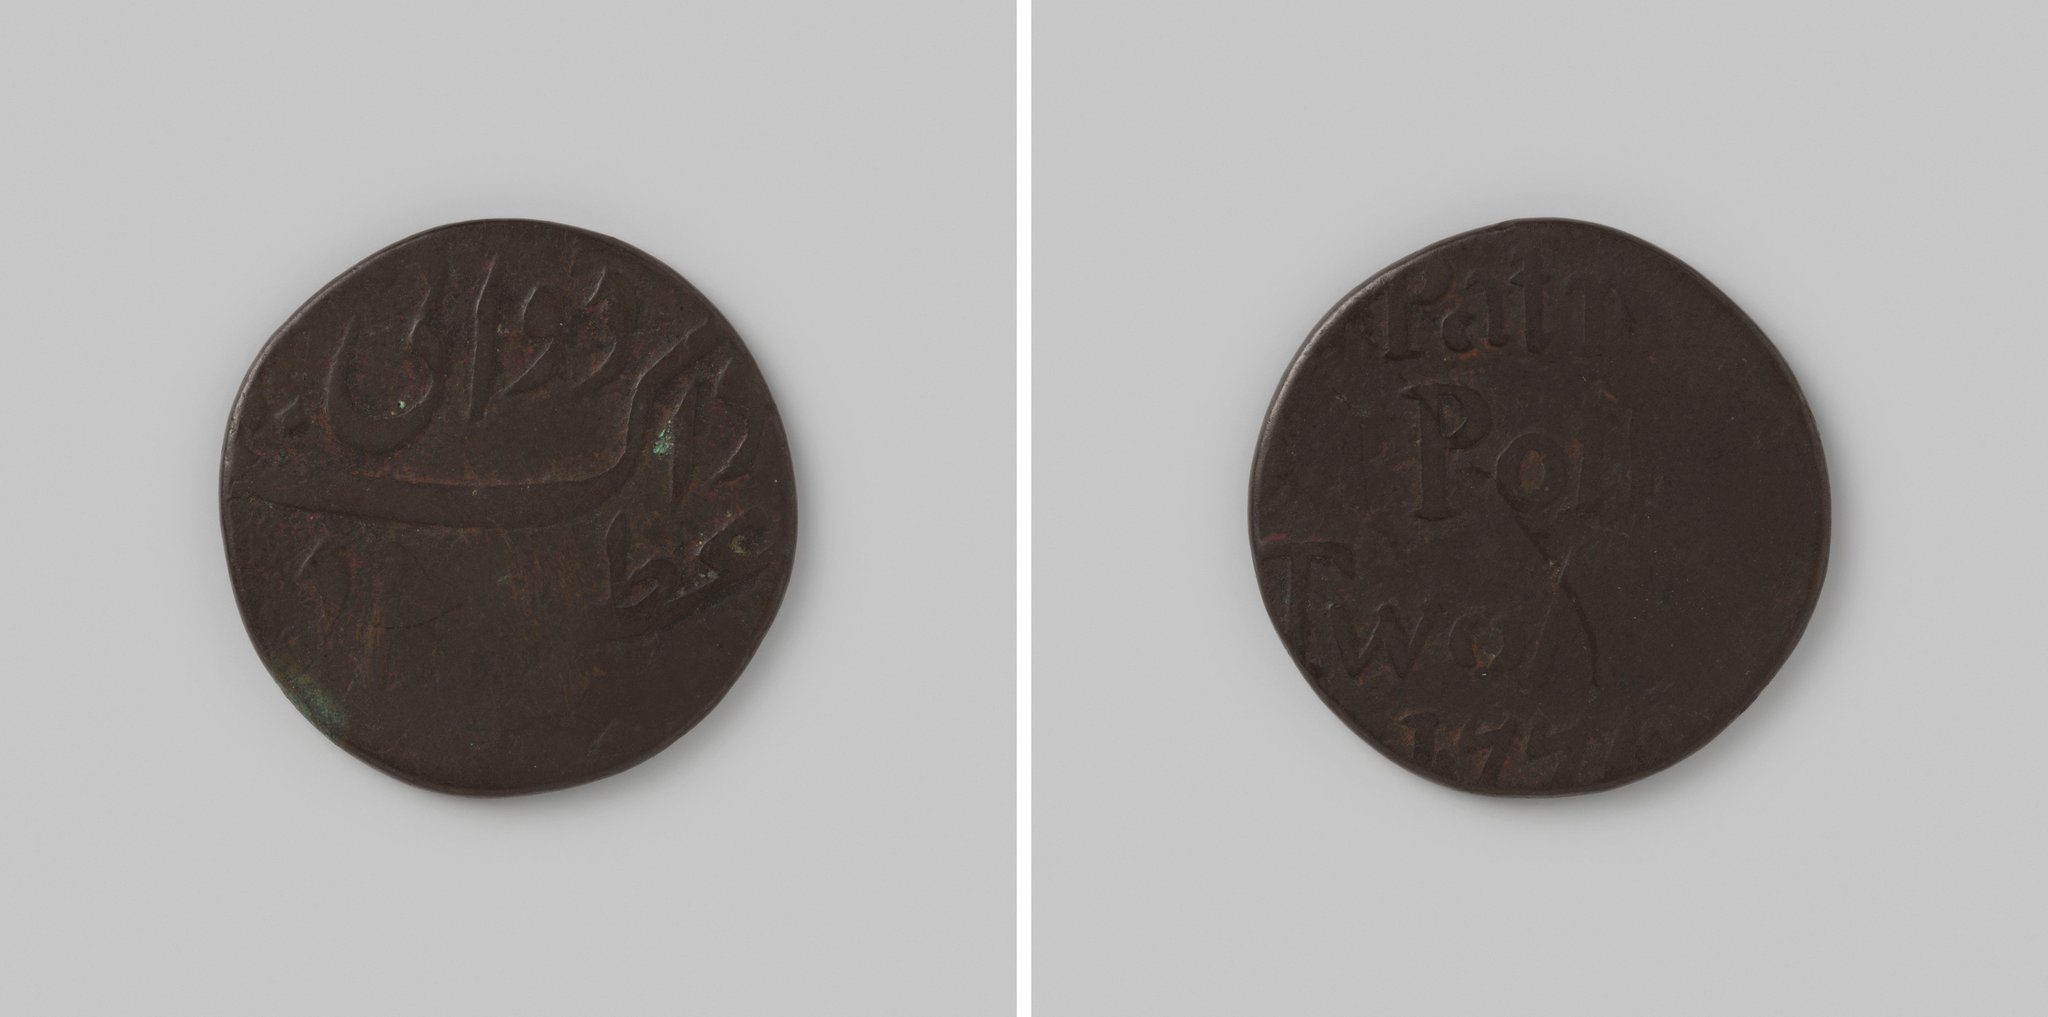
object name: coin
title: 2 anna uit Bengalen in India van de Engelse Oostindische Compagnie (EIC) op naam van Sjah Alam I, 1774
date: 1774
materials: copper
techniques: striking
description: Koperen munt. Voorzijde: in Arabische lettertekens in drie regels opschrift. Keerzijde: in een regel waarde-aanduiding: Two Ann. Daarboven in twee regels aanduiding: Patna Post en daaronder jaartal: 1774. Gladde rand.